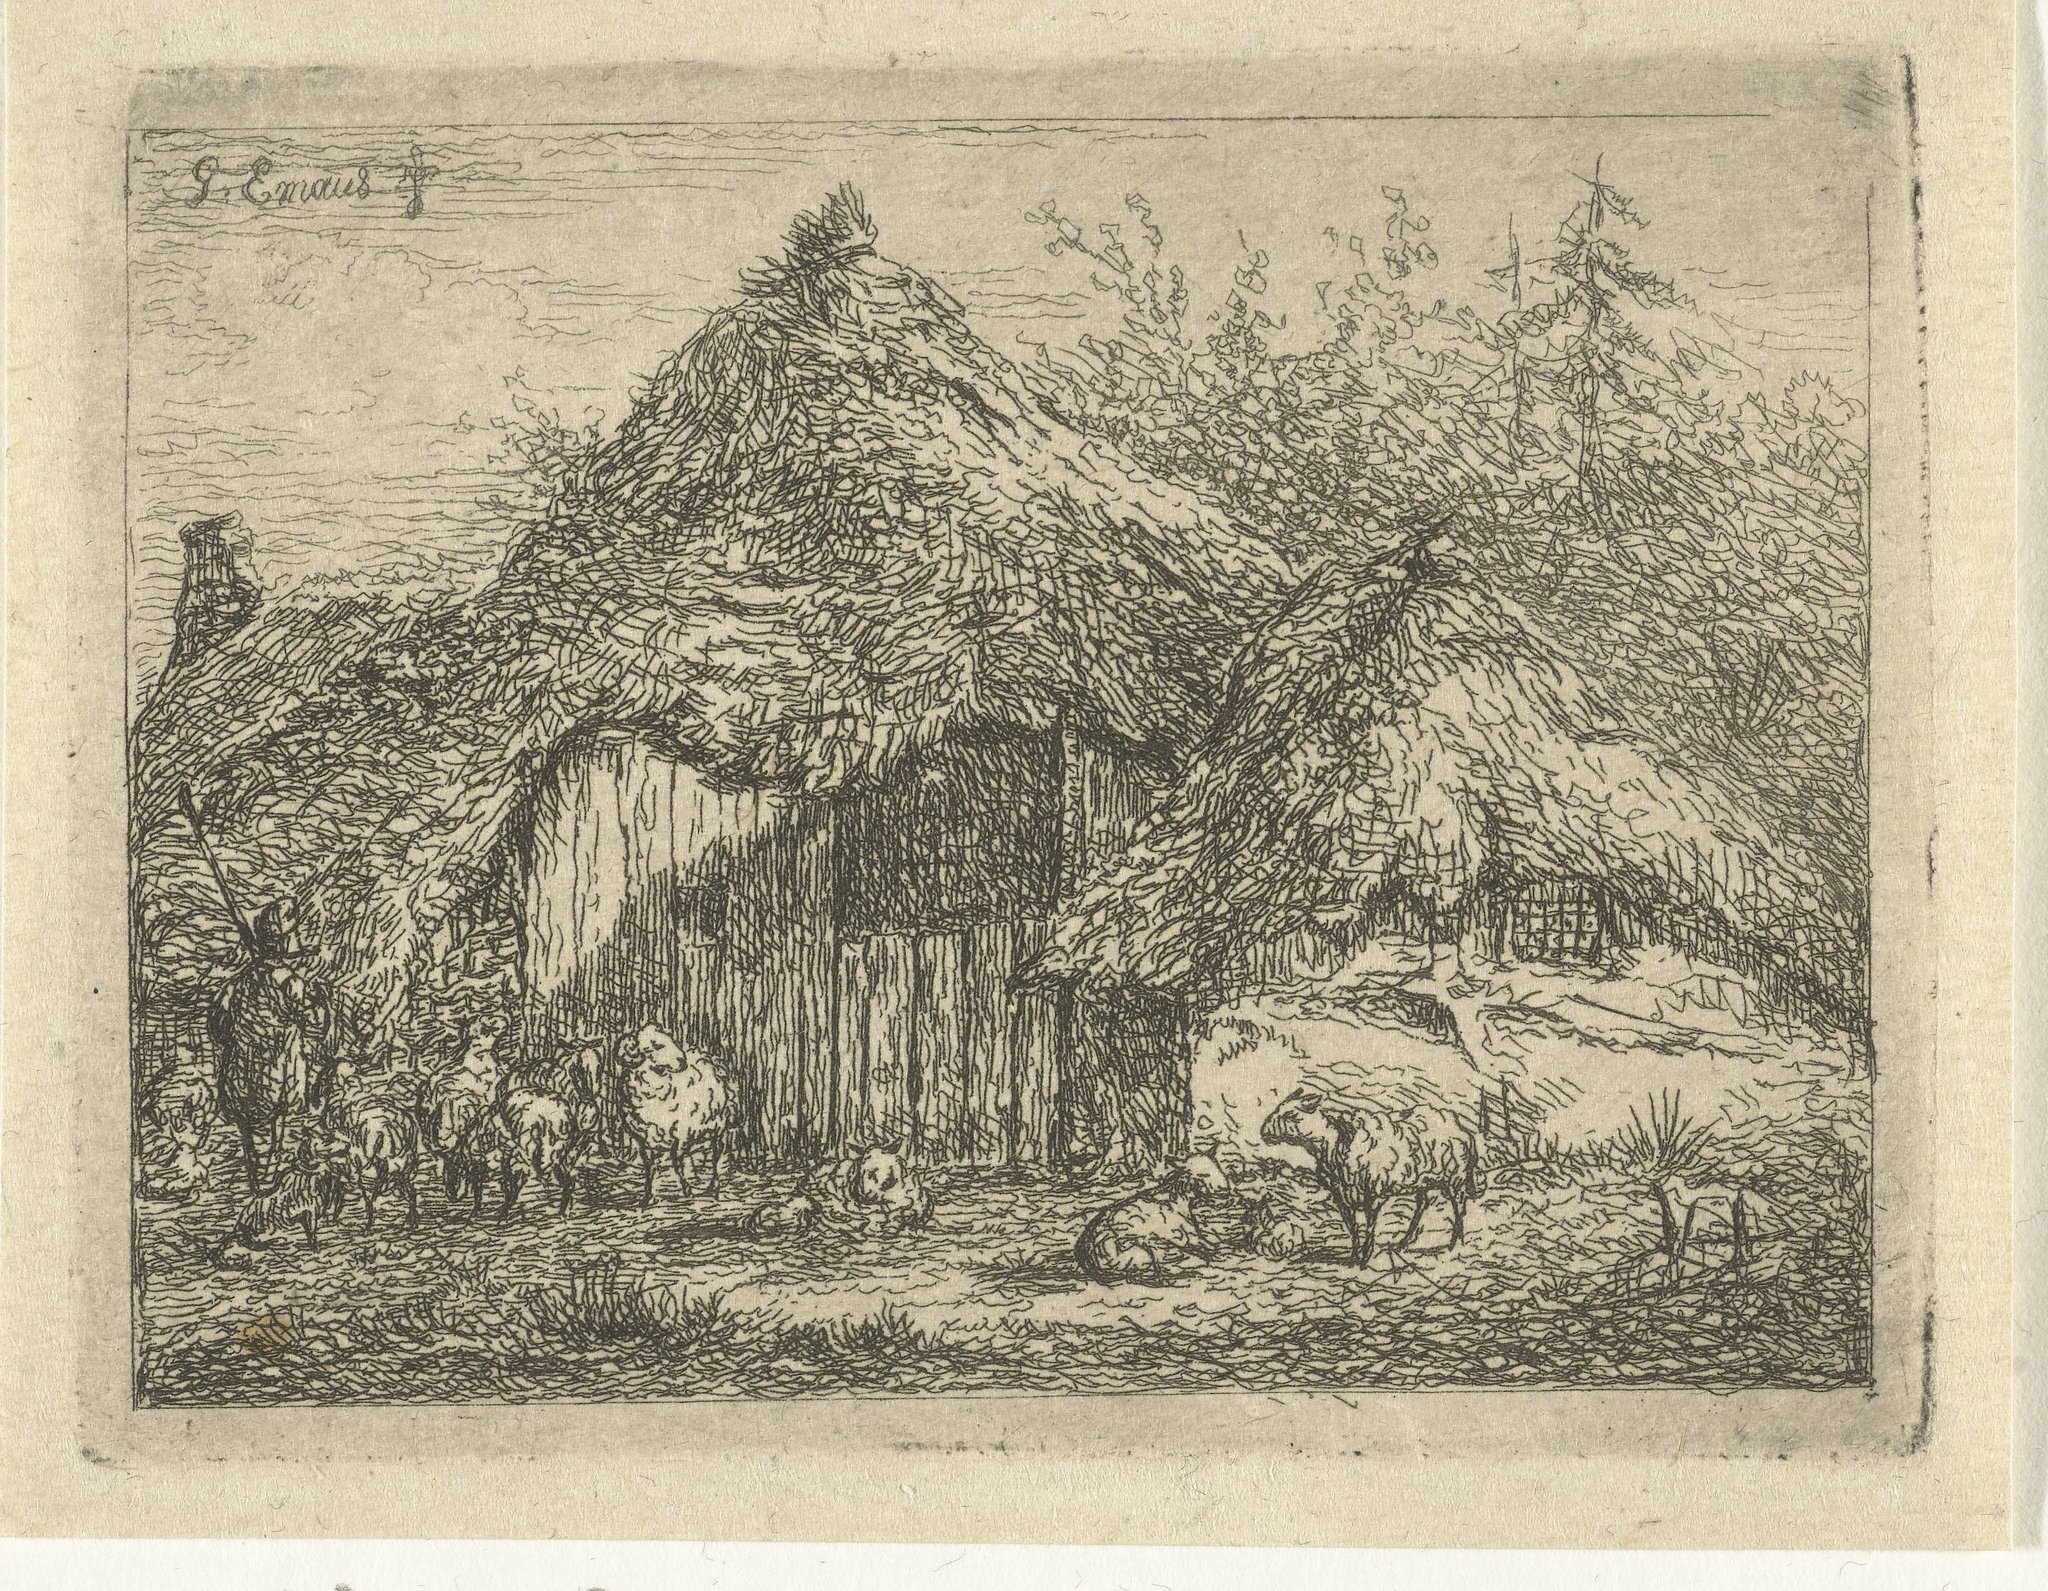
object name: print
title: Schaapsherder bij plaggenhut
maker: gerardus emaus de micault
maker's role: draughtsman, print maker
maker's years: 1798-1863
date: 1813-1863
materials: paper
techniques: etching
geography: netherlands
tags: herding, herdsman, herdswoman, shepherd, shepherdess, cowherd, etc.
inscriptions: collector's mark: Lugt 2228